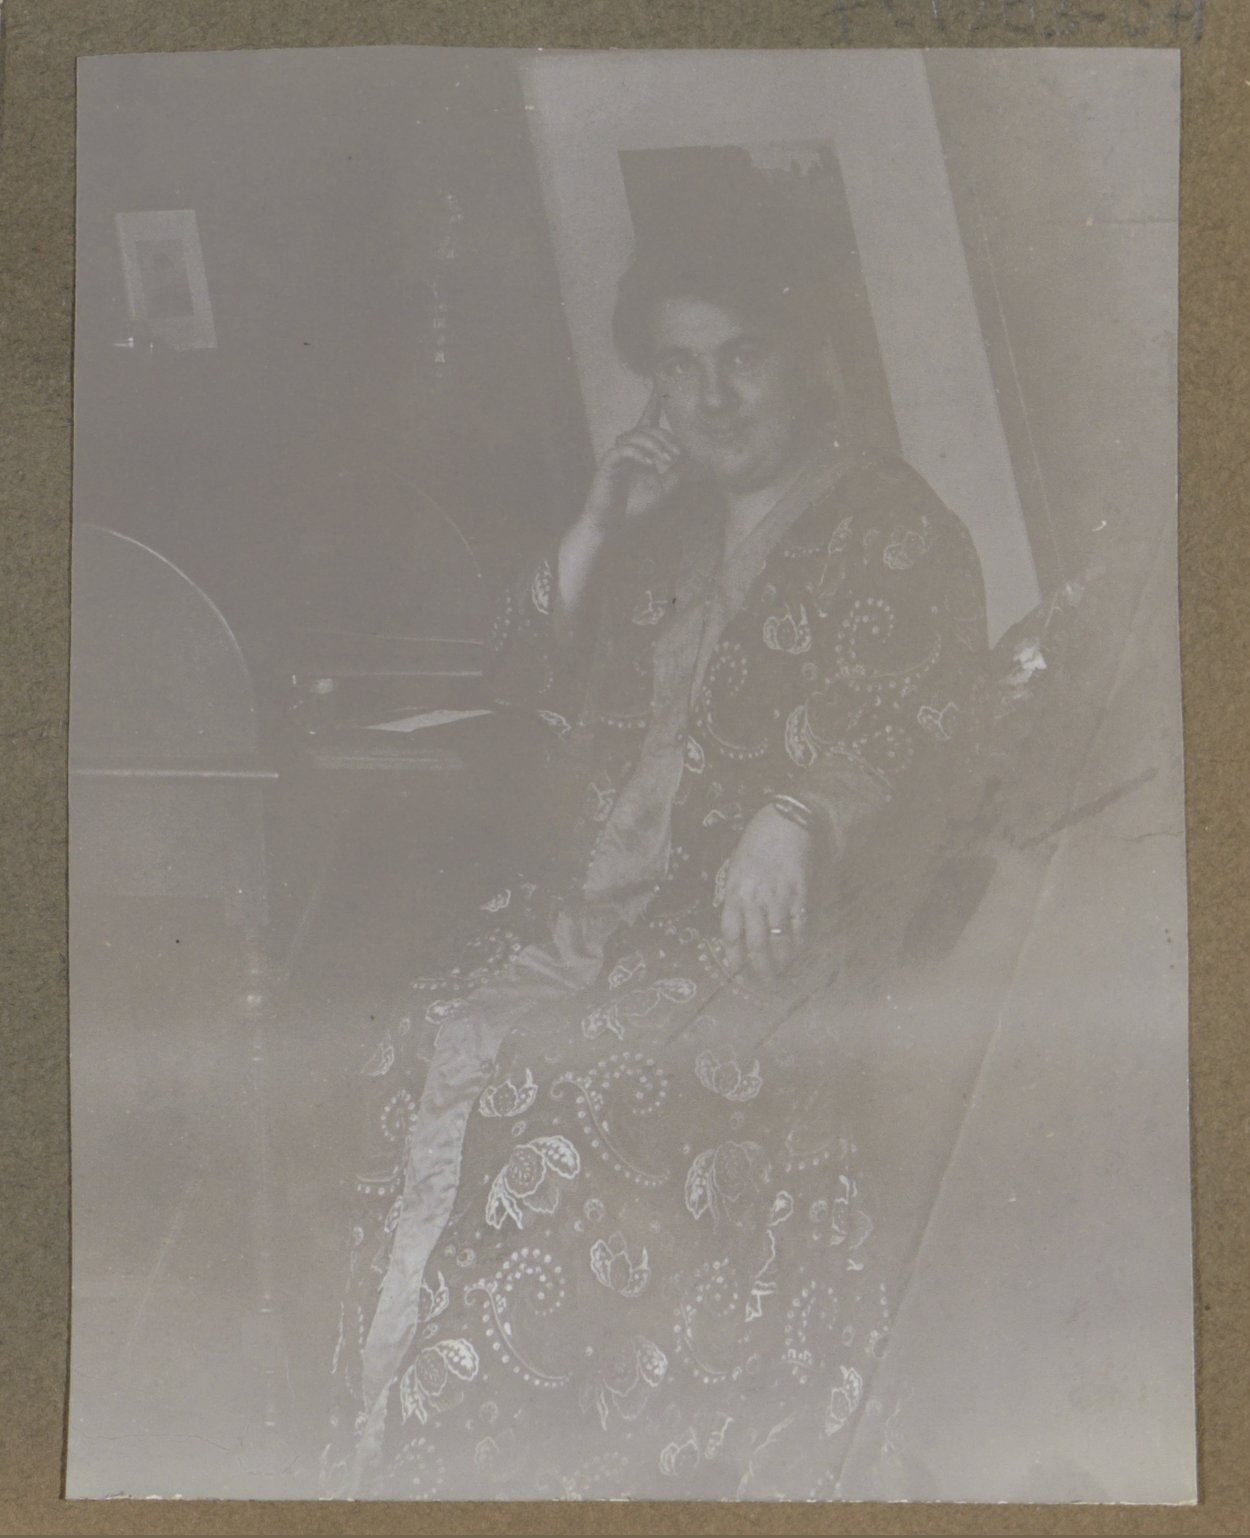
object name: photograph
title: Portret van een onbekende vrouw, zittend aan een bureau, mogelijk in Suriname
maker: Anonymous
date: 1920-1930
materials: photographic support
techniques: gelatin silver print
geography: suriname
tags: adult woman, suriname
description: Onderdeel van fotoalbum van een onbekende Nederlandse familie met opnames van Suriname, Europa en Nederlands-Indië.